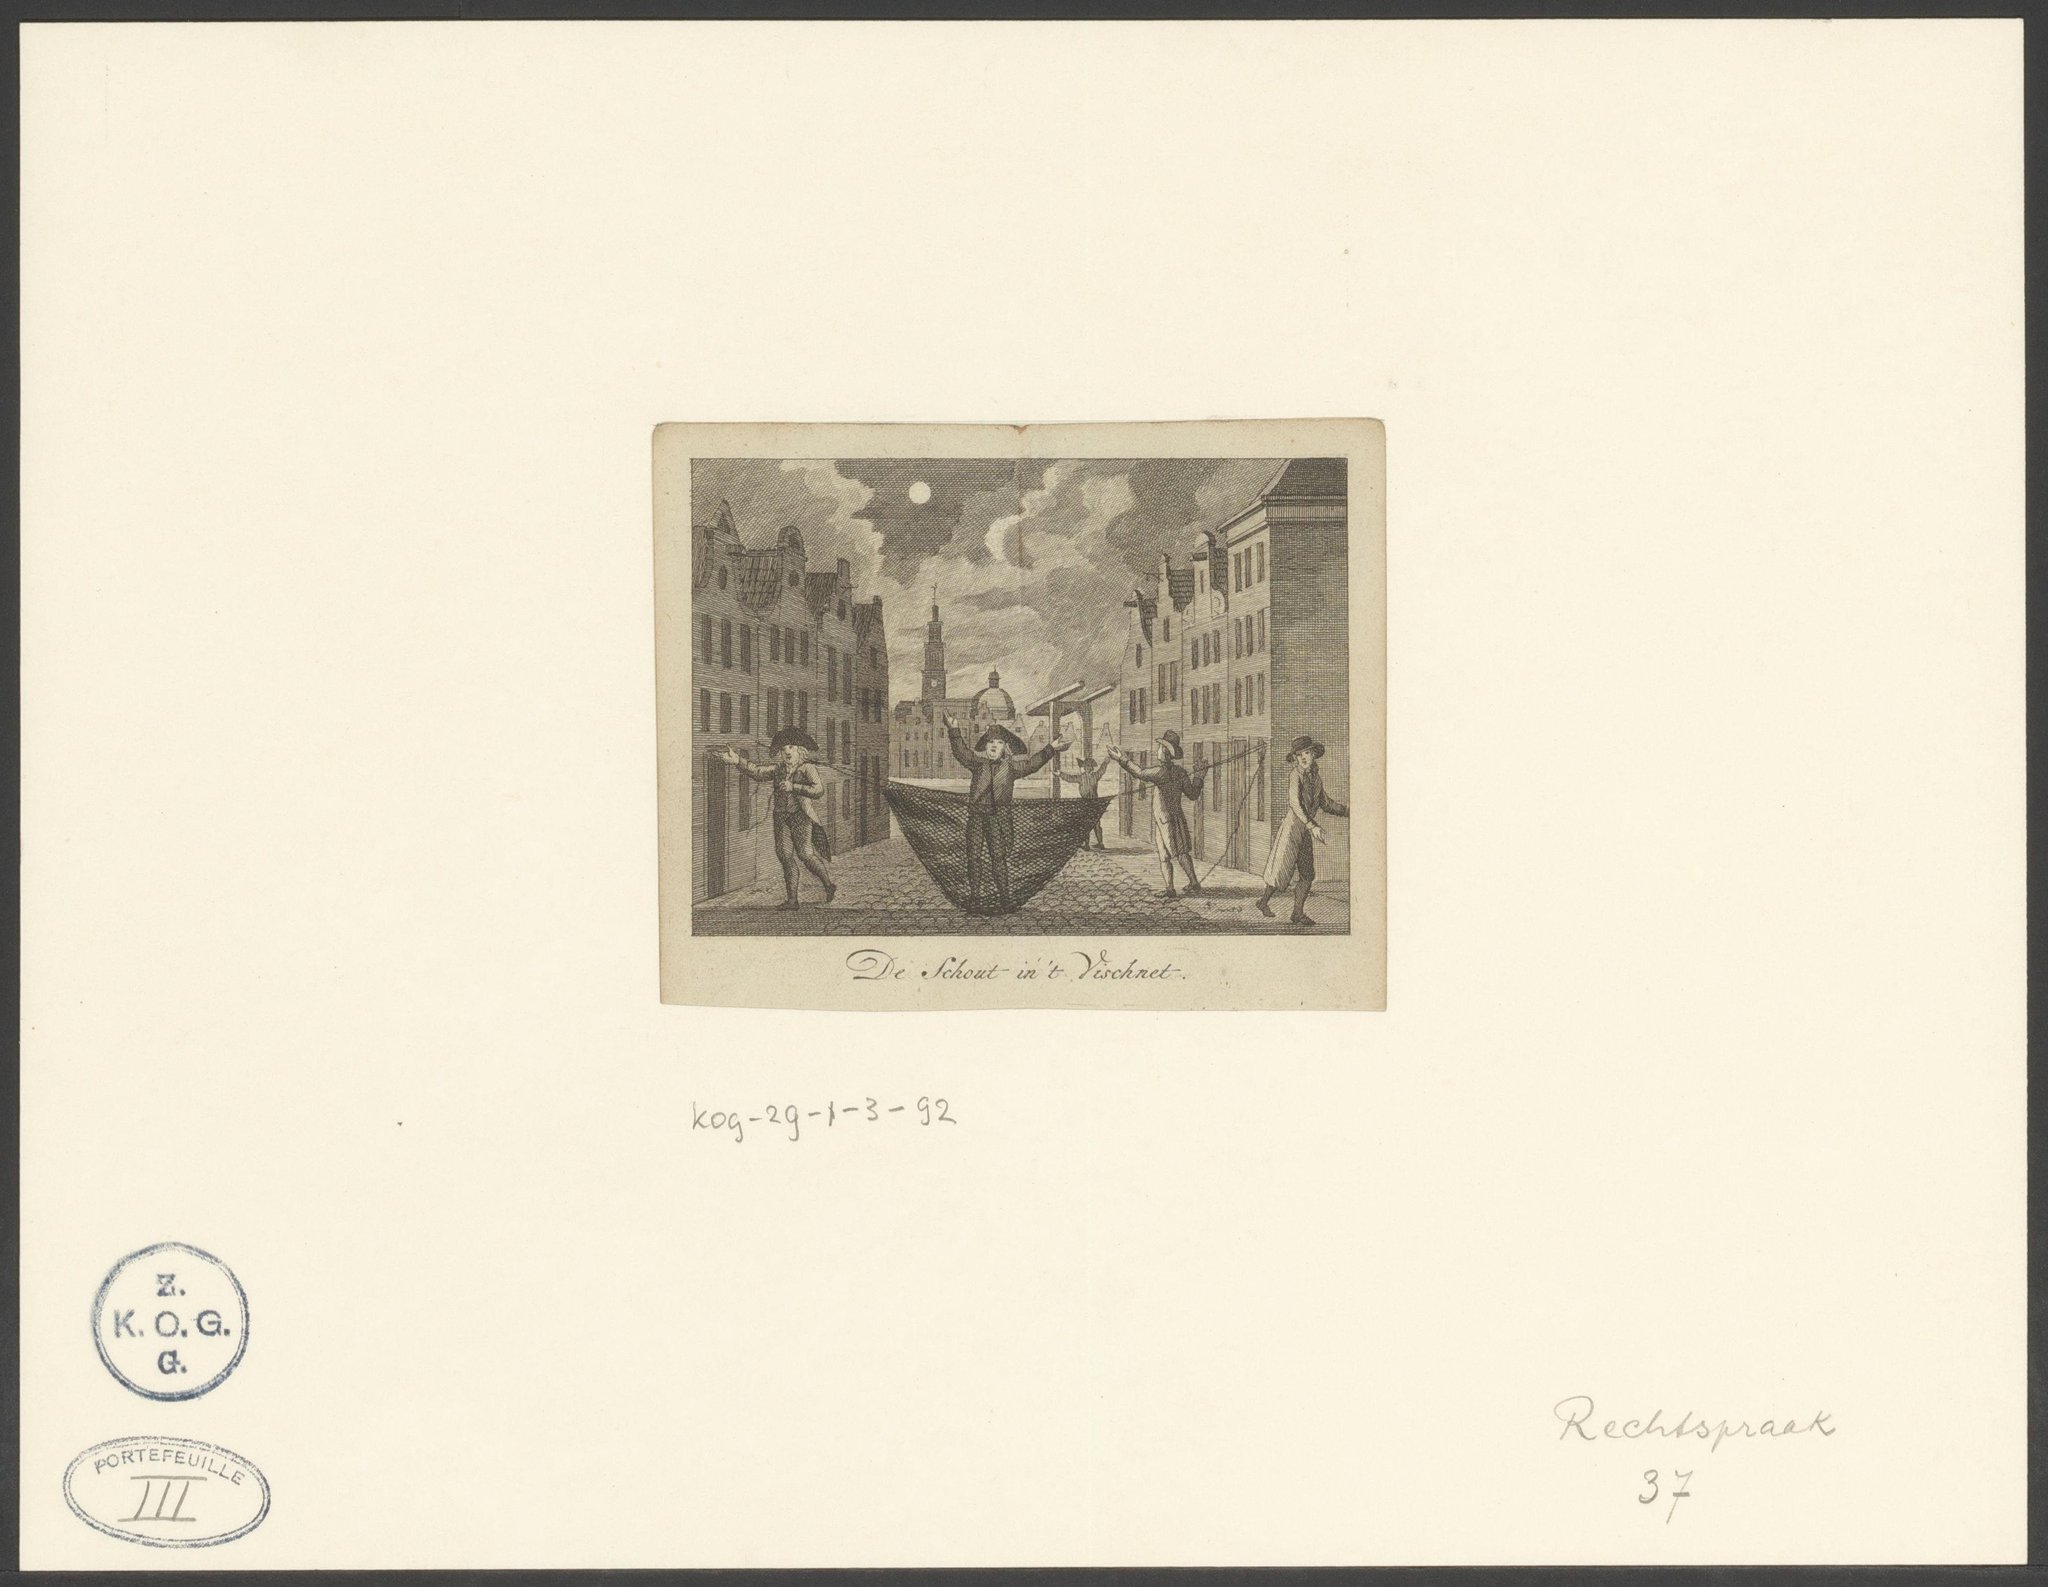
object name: print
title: Schout die in een visnet staat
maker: Anonymous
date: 1750-1849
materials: paper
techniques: etching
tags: fishing net, magistracy, judges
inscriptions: collector's mark: Lugt 1641, stamp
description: Onderwerpsrubrieken binnen de Atlas Zeden en Gewoonten: Regeering, Rechtswezen.